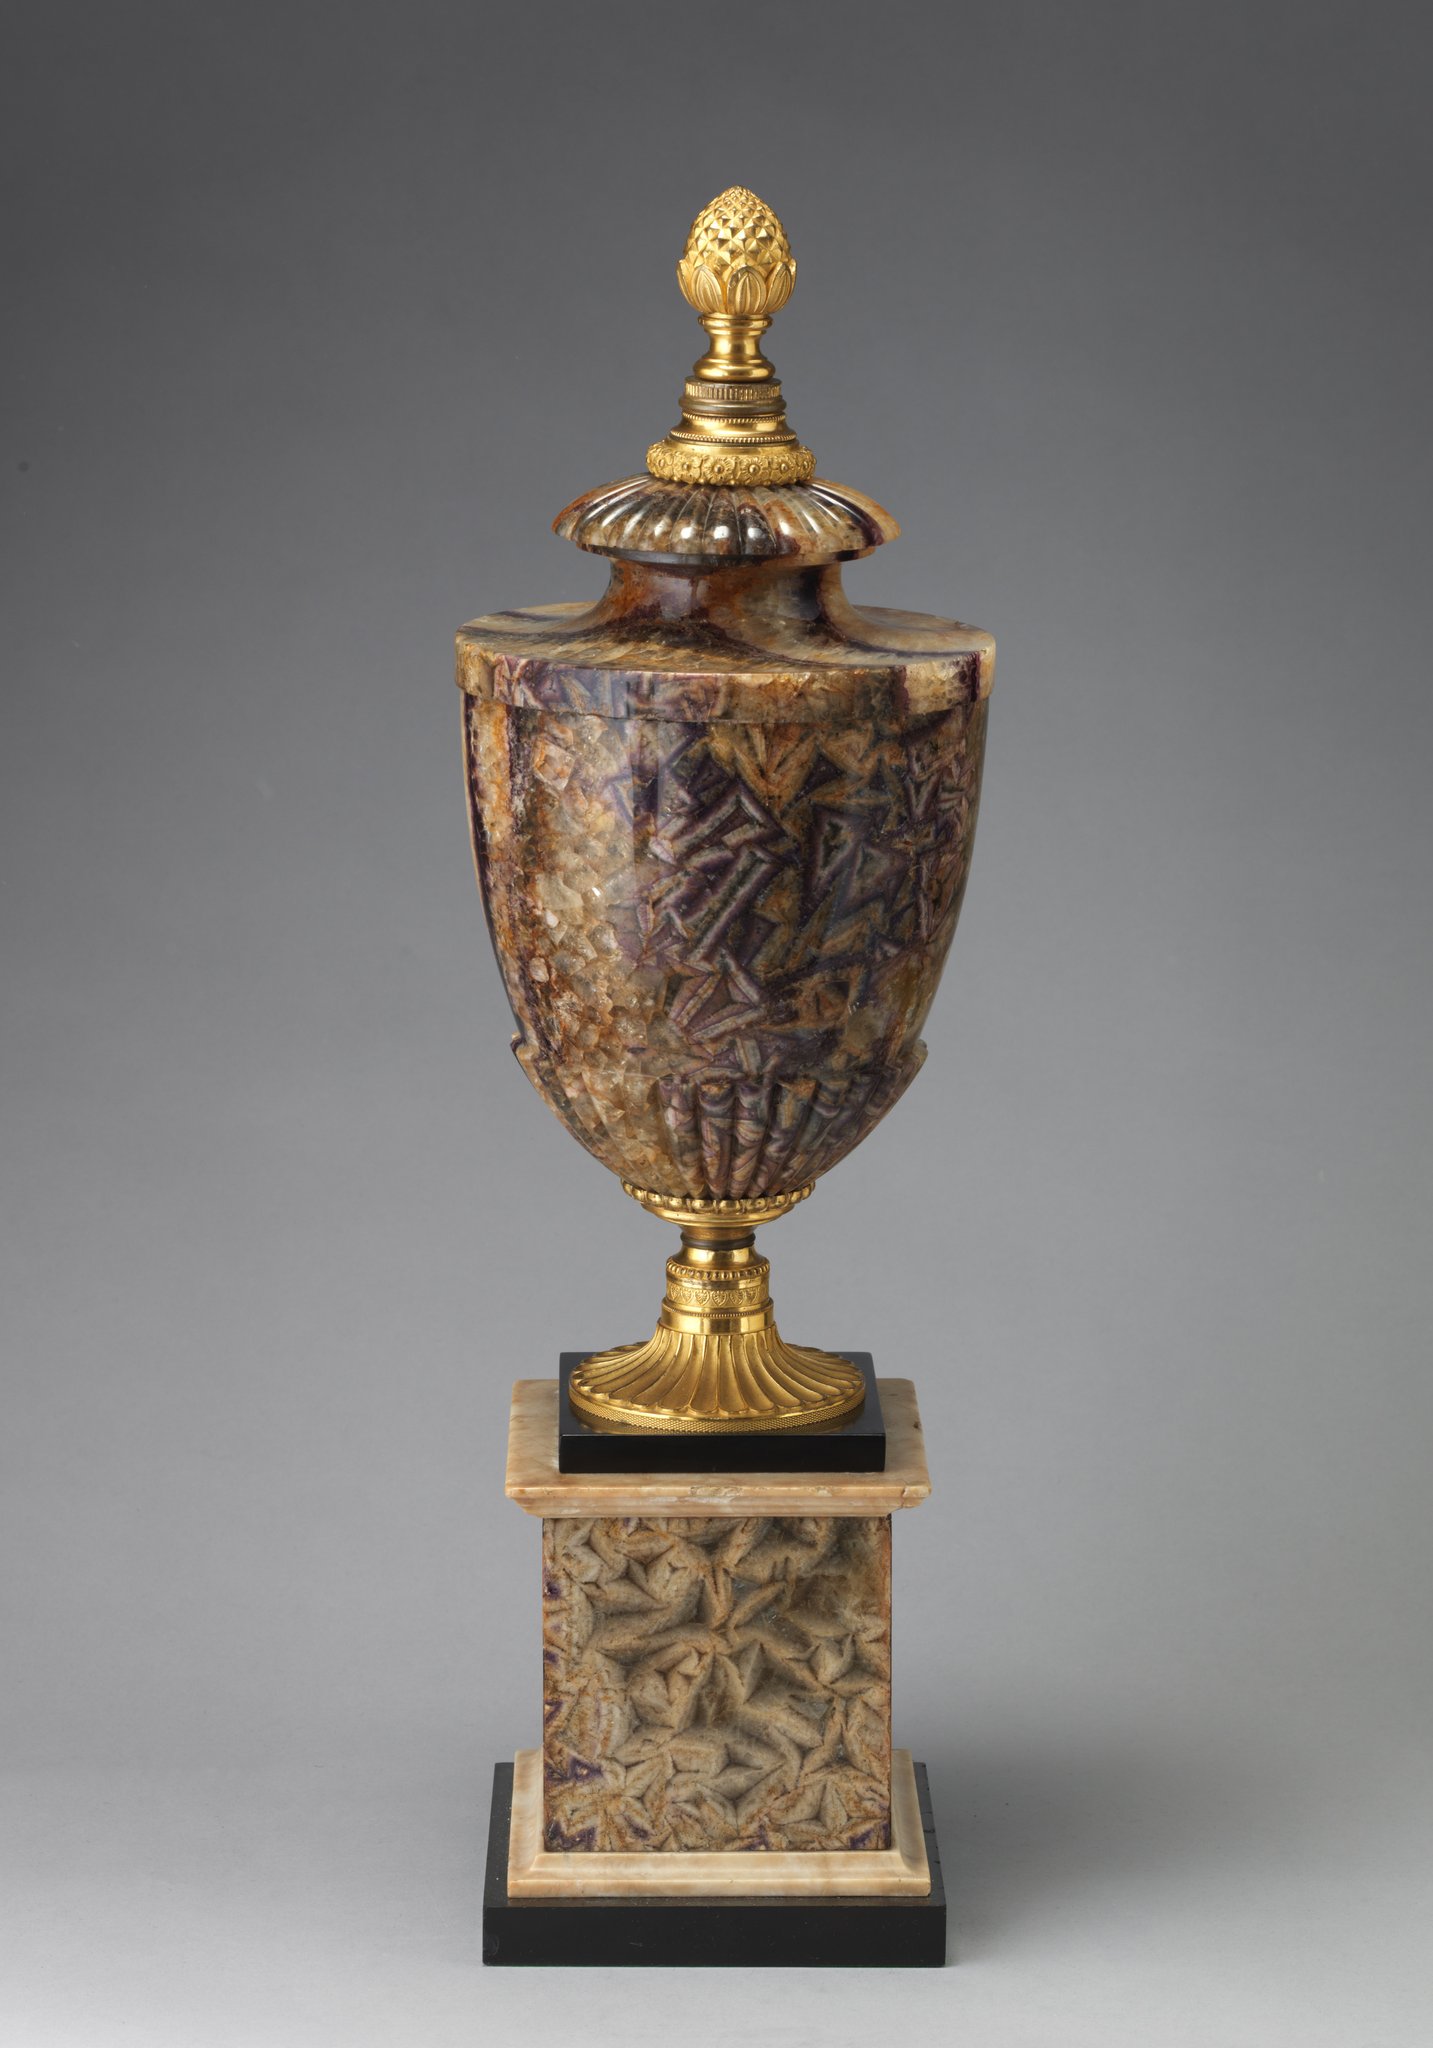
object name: urn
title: Ormolu-mounted urn on square base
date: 1790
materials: gilt bronze, marble